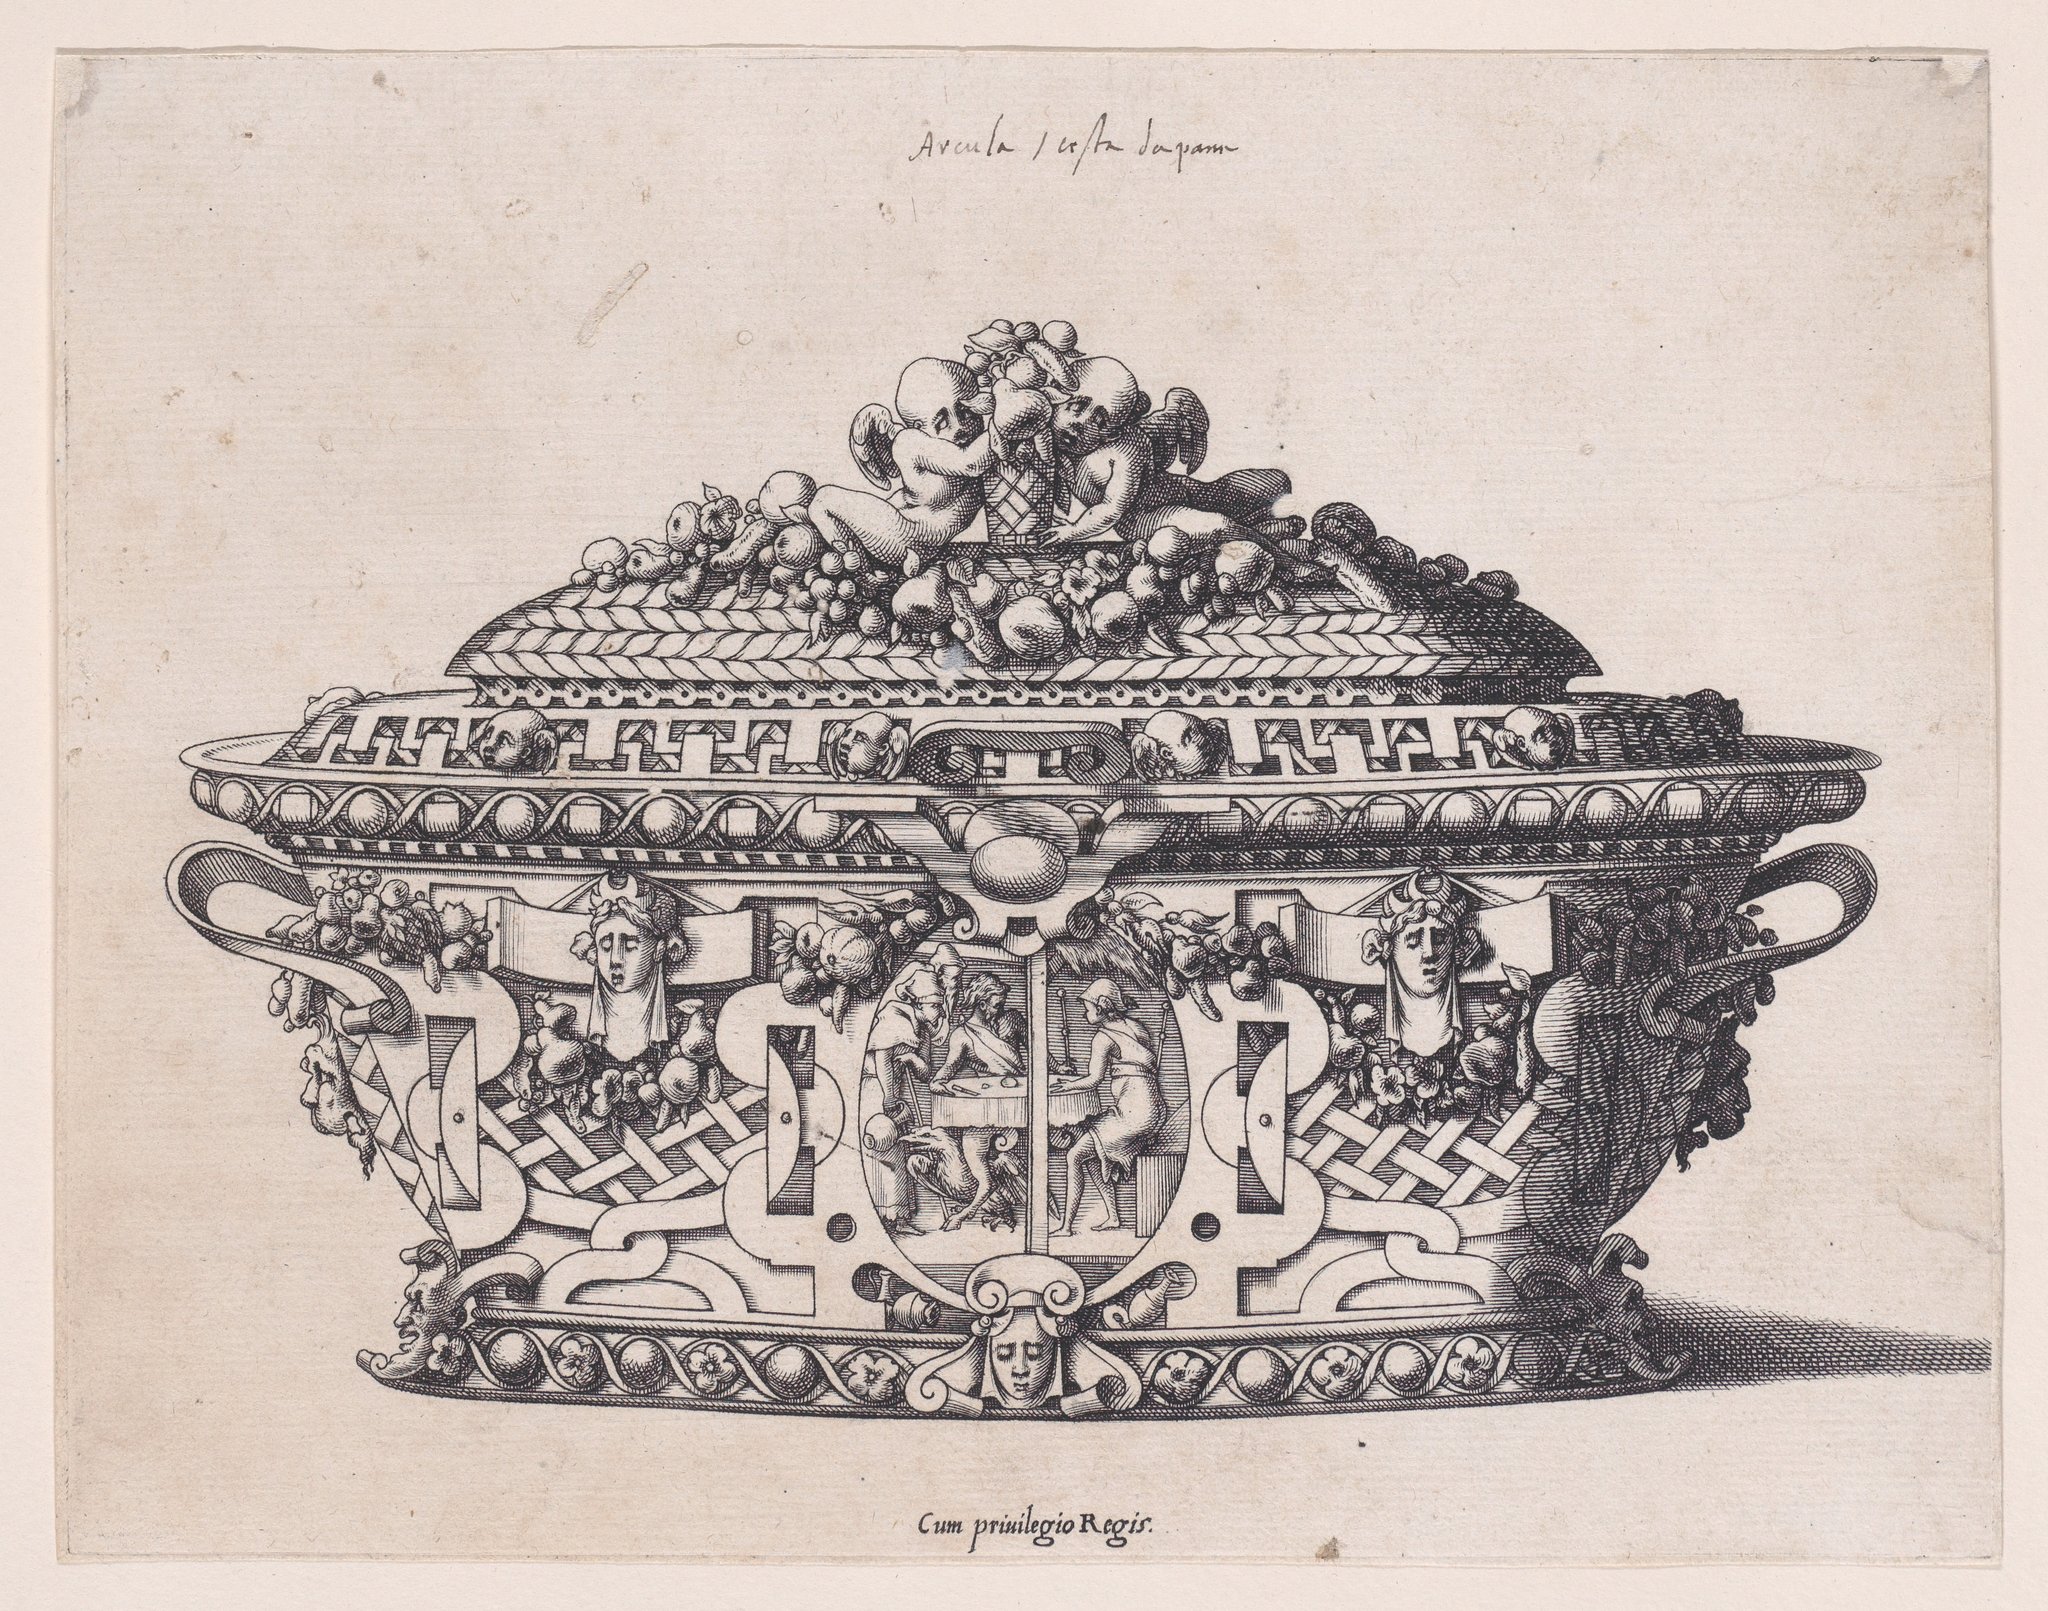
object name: print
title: Basket with Two Handles (Corbeille à deux anses)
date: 1525-1600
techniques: engraving